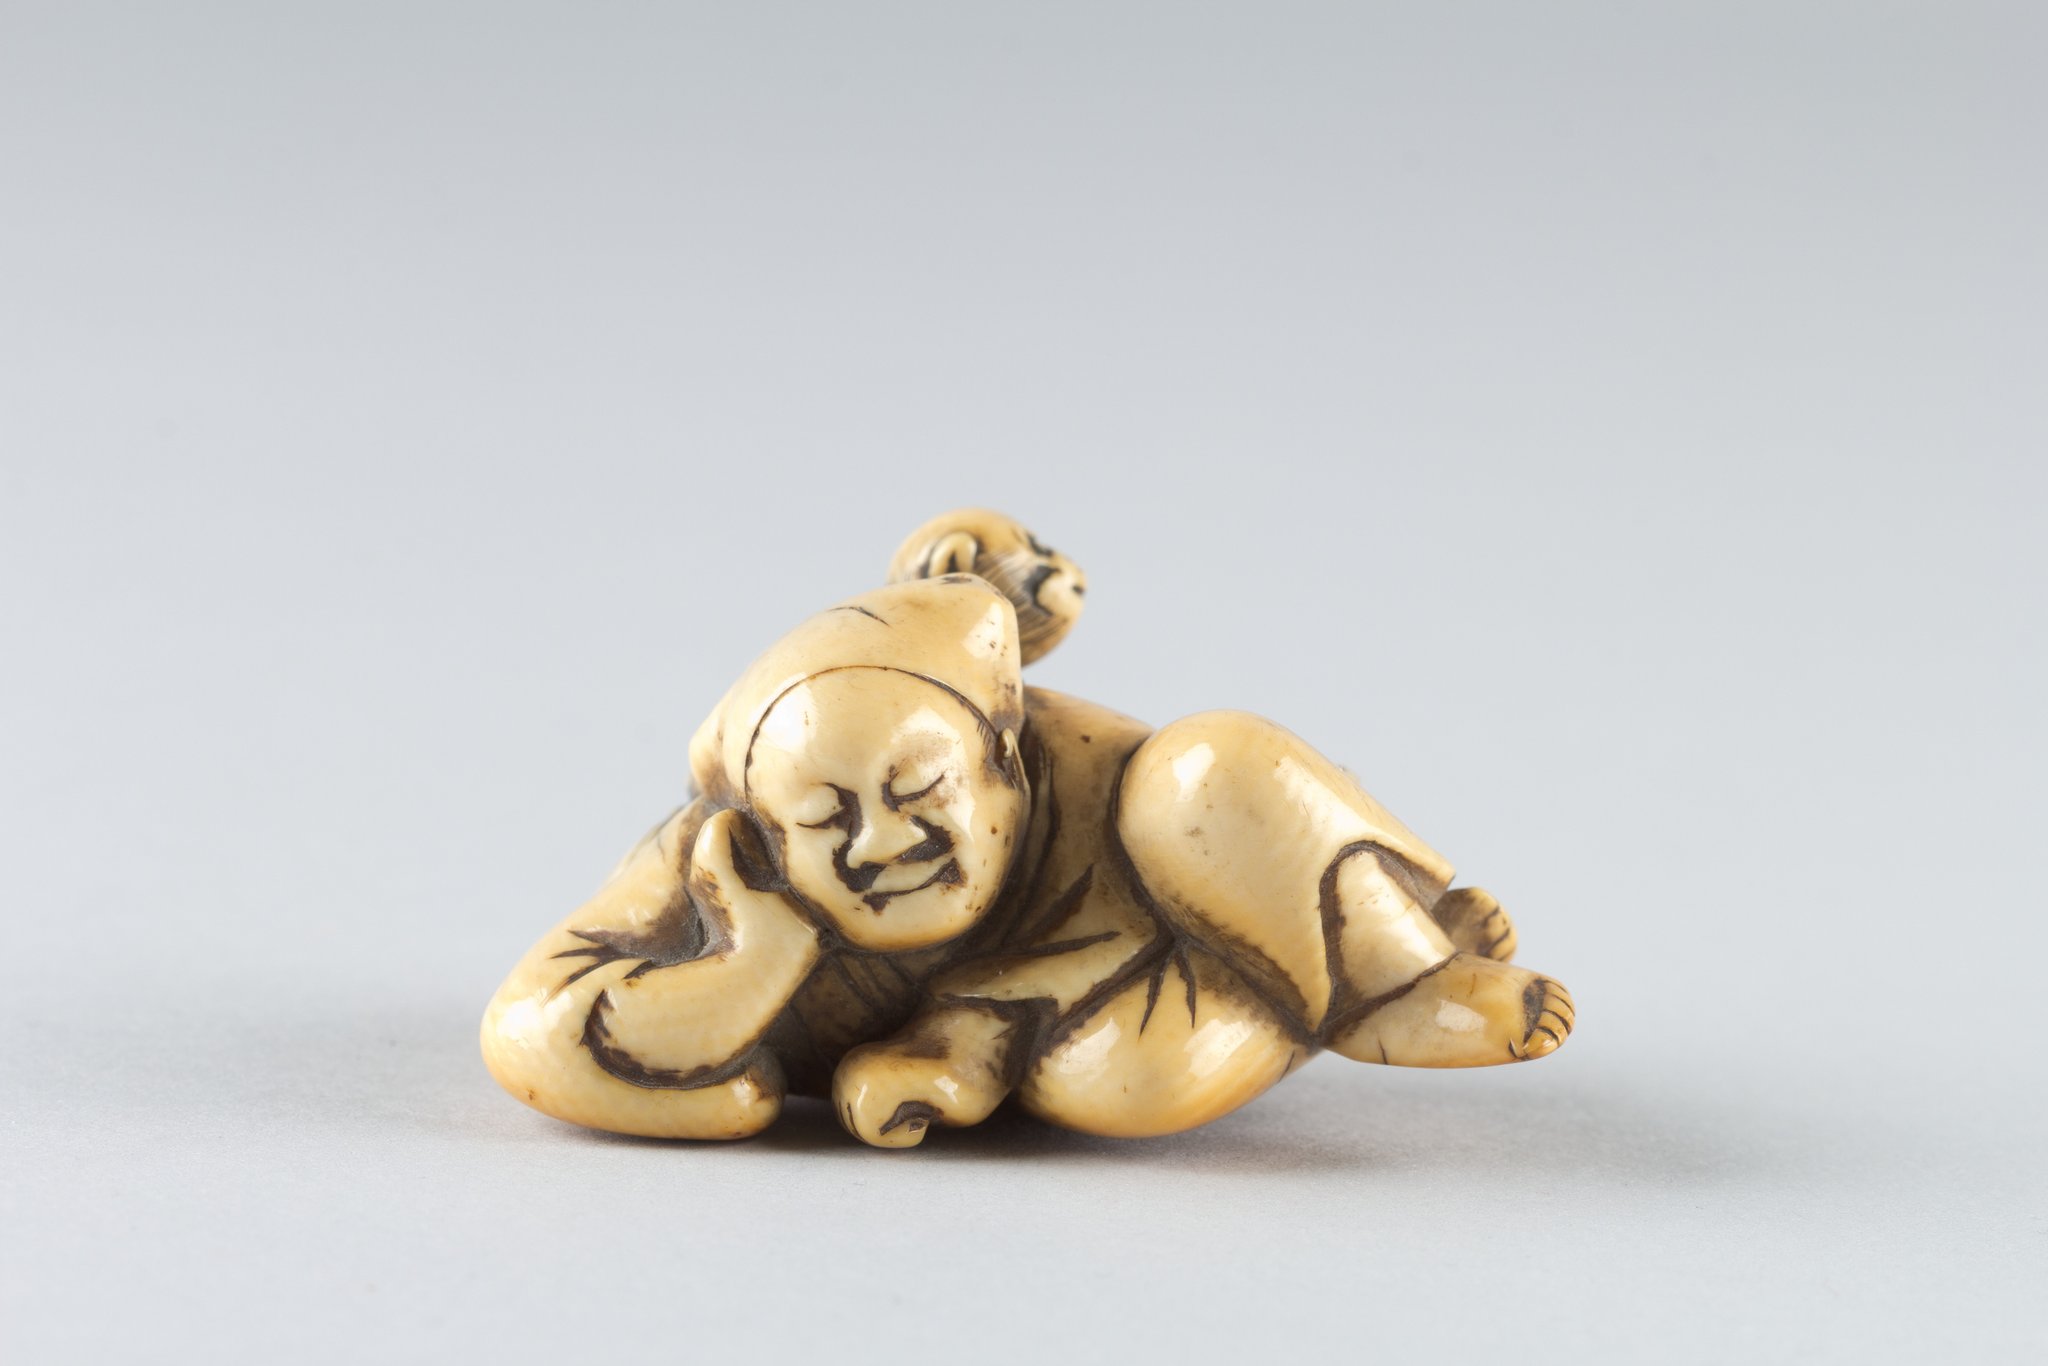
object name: netsuke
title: Netsuke of a Man Sleeping while Monkey Steals Contents of Basket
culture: japanese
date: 1801-1900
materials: ivory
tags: men,monkeys